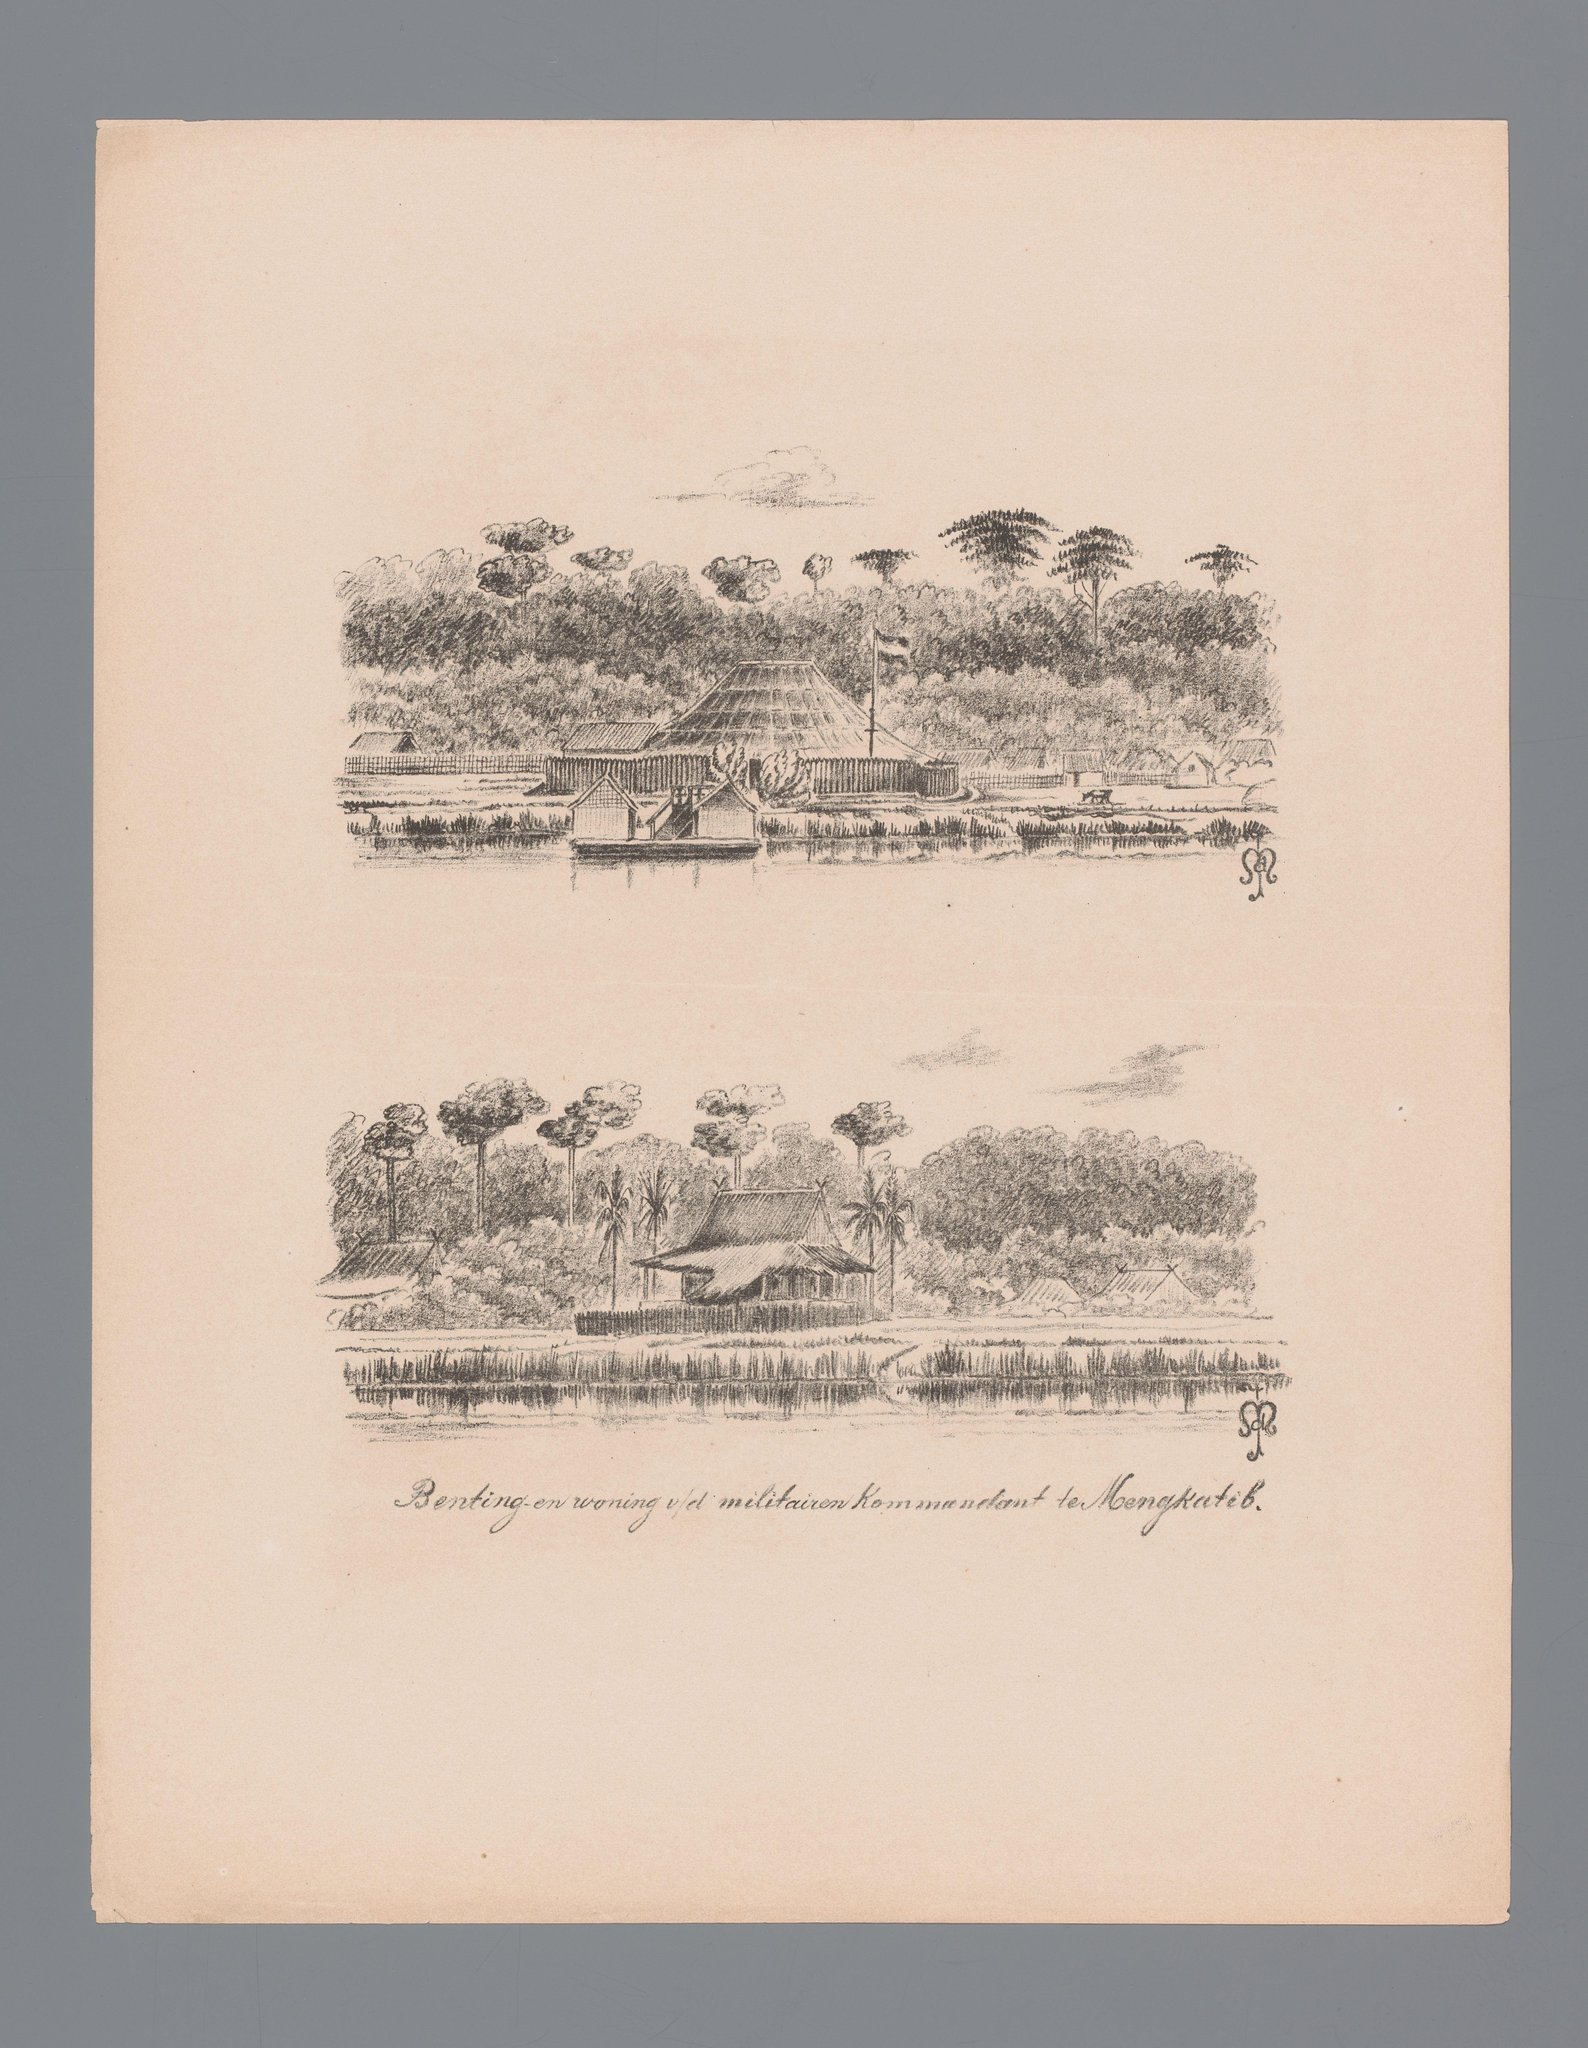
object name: print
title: Vestingwerk en woning van een commandant op Borneo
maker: willem mathol de jong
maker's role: print maker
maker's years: 1828-1886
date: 1838-1886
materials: paper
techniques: lithograph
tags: river, fortifications, military engineering, borneo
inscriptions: collector's mark: Lugt 2228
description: Beiden liggen aan een rivier. Maakt deel uit van een omslag met twaalf prenten.